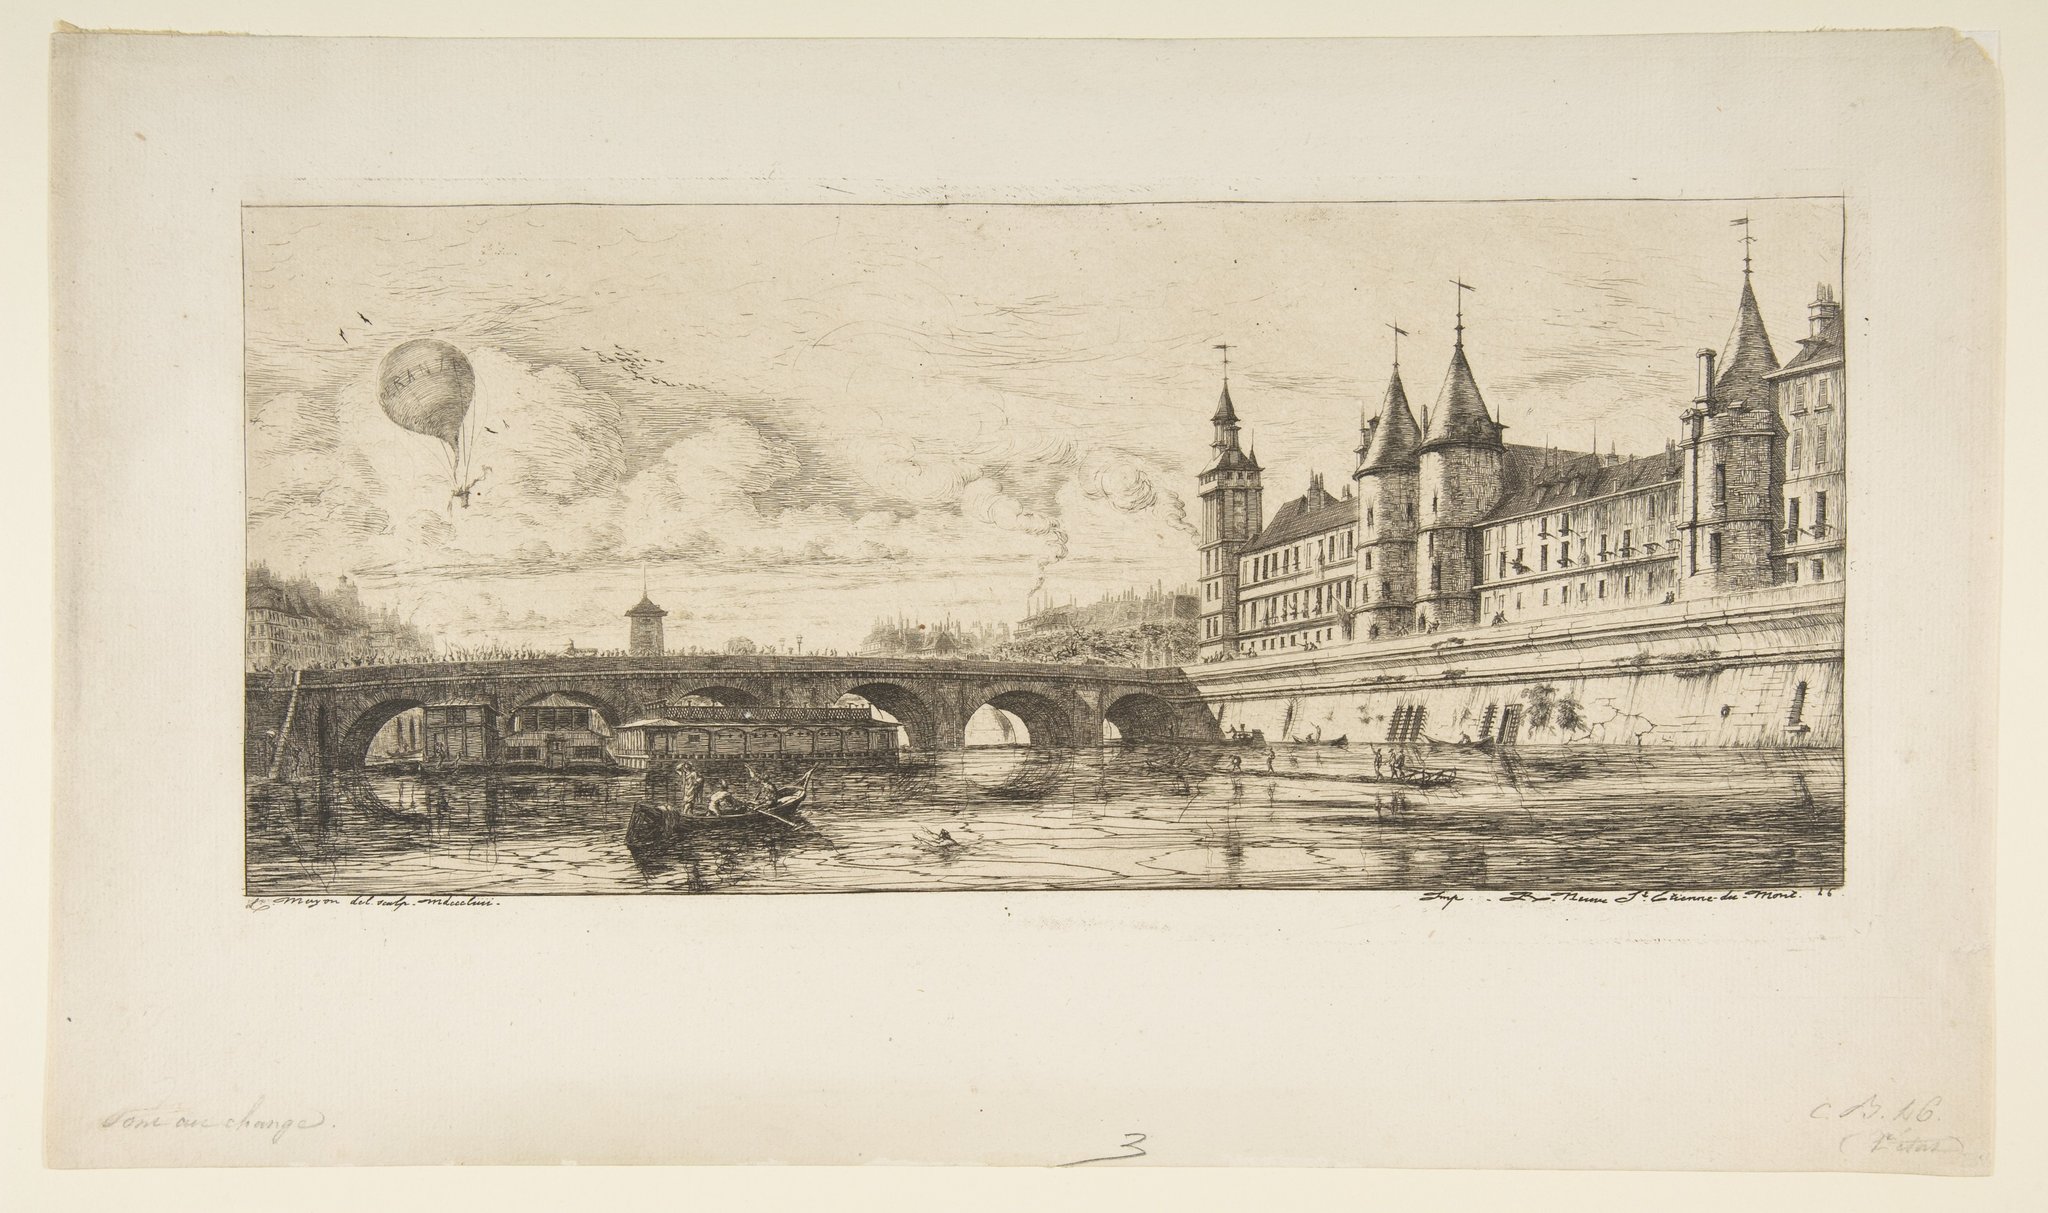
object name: print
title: Pont-au-change, Paris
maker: charles meryon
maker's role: artist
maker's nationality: french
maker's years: 1821-1868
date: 1854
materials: paper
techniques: drypoint, etching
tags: buildings,bridges,rivers,boats,paris